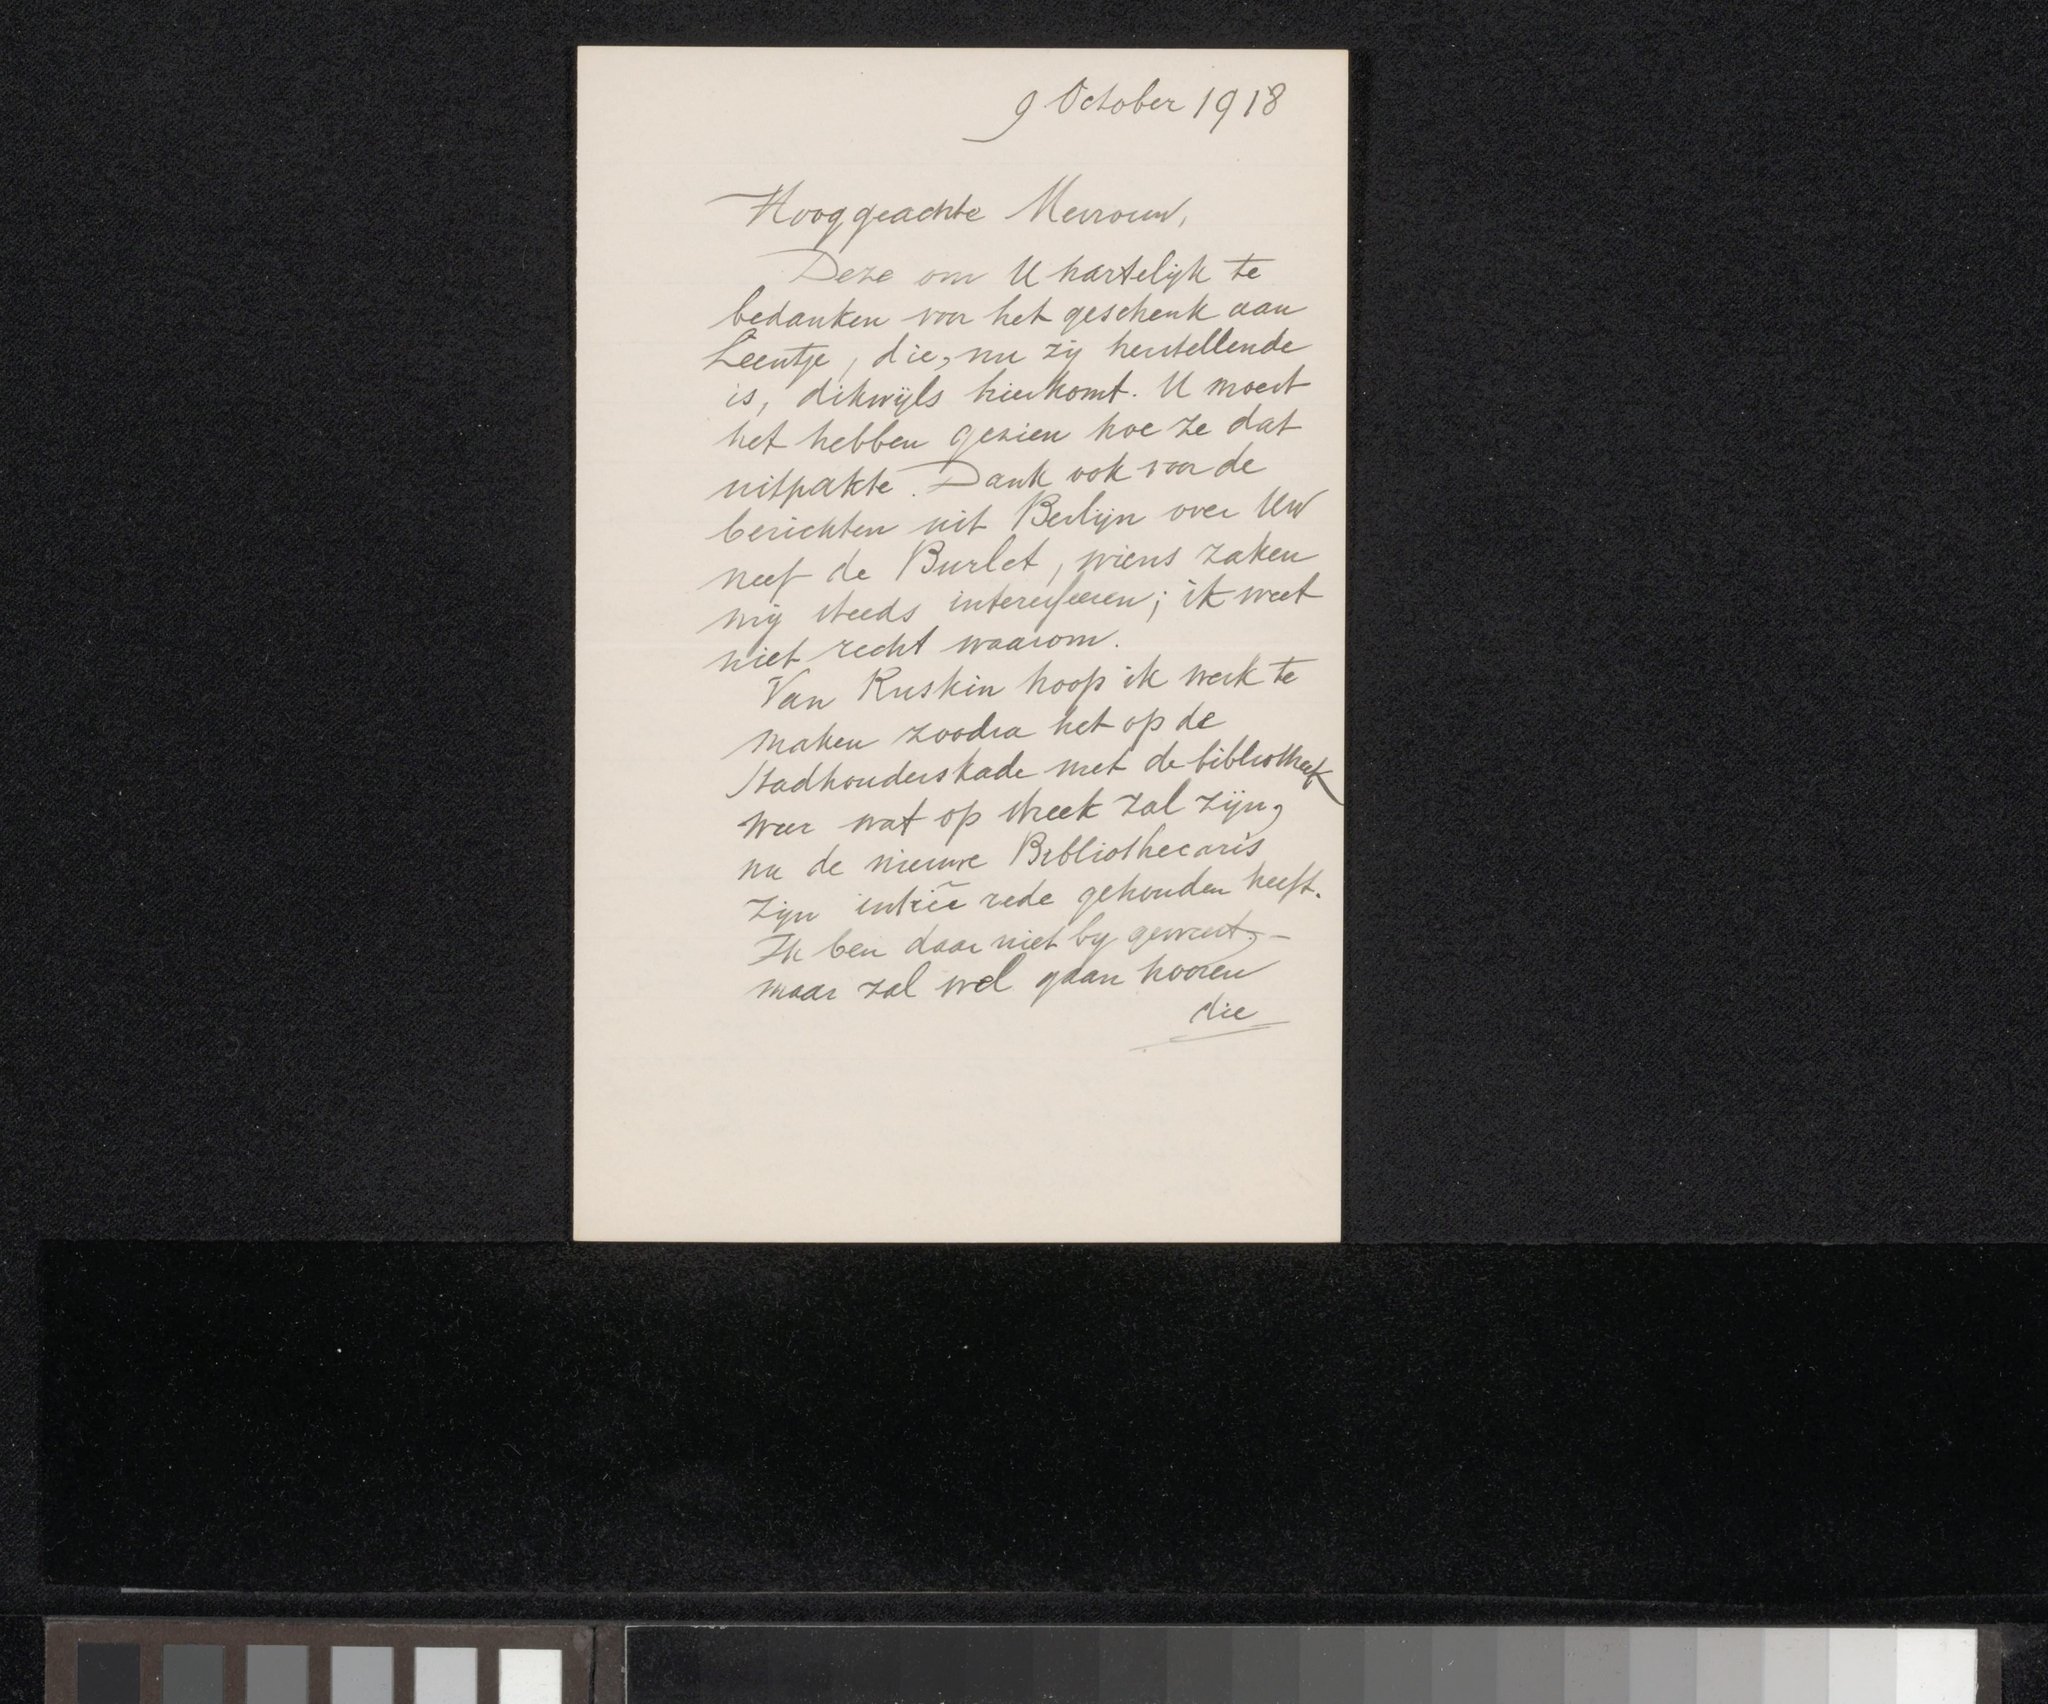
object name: letter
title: Brief aan Anne Antoinette Weber-Van Bosse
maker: august allebé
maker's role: draughtsman, print maker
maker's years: 1838-1927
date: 1918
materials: ink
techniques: pen, writing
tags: rotterdam, charles albert de burlet, painter, designer, jan veth, anne antoinette weber-van bosse, london, john ruskin, richard nicolaüs roland holst, diseases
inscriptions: watermark